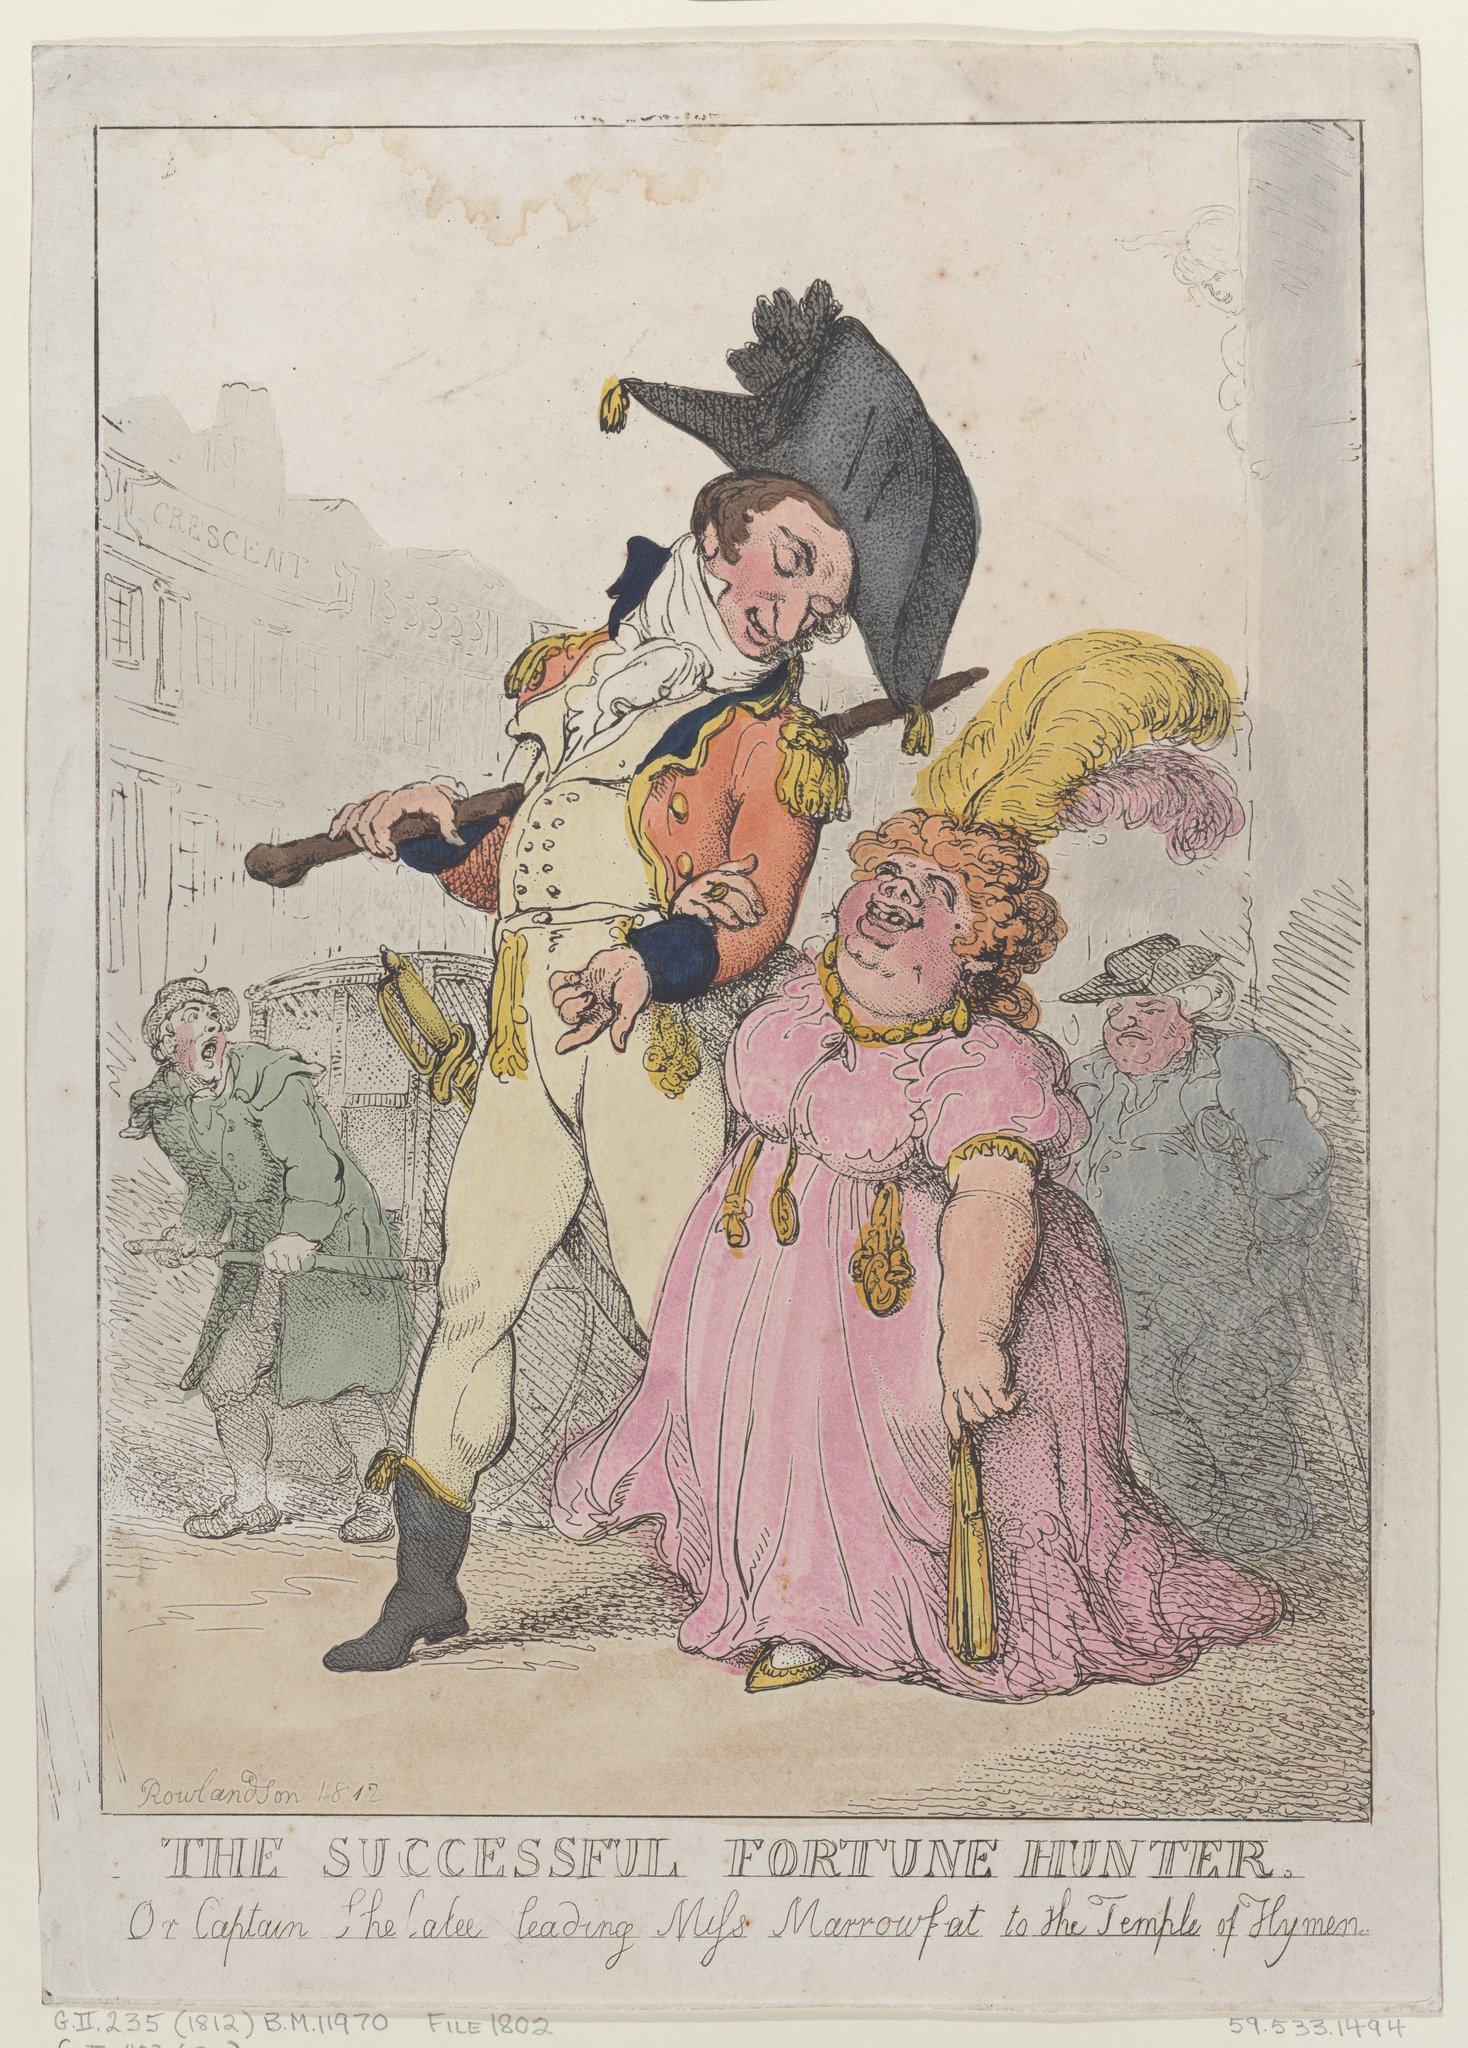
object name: print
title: The Successful Fortune Hunter, or Captain Shelalee Leading Miss Marrowfat to the Temple of Hymen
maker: thomas rowlandson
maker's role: artist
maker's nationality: british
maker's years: 1757-1827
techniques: etching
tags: satire,men,women